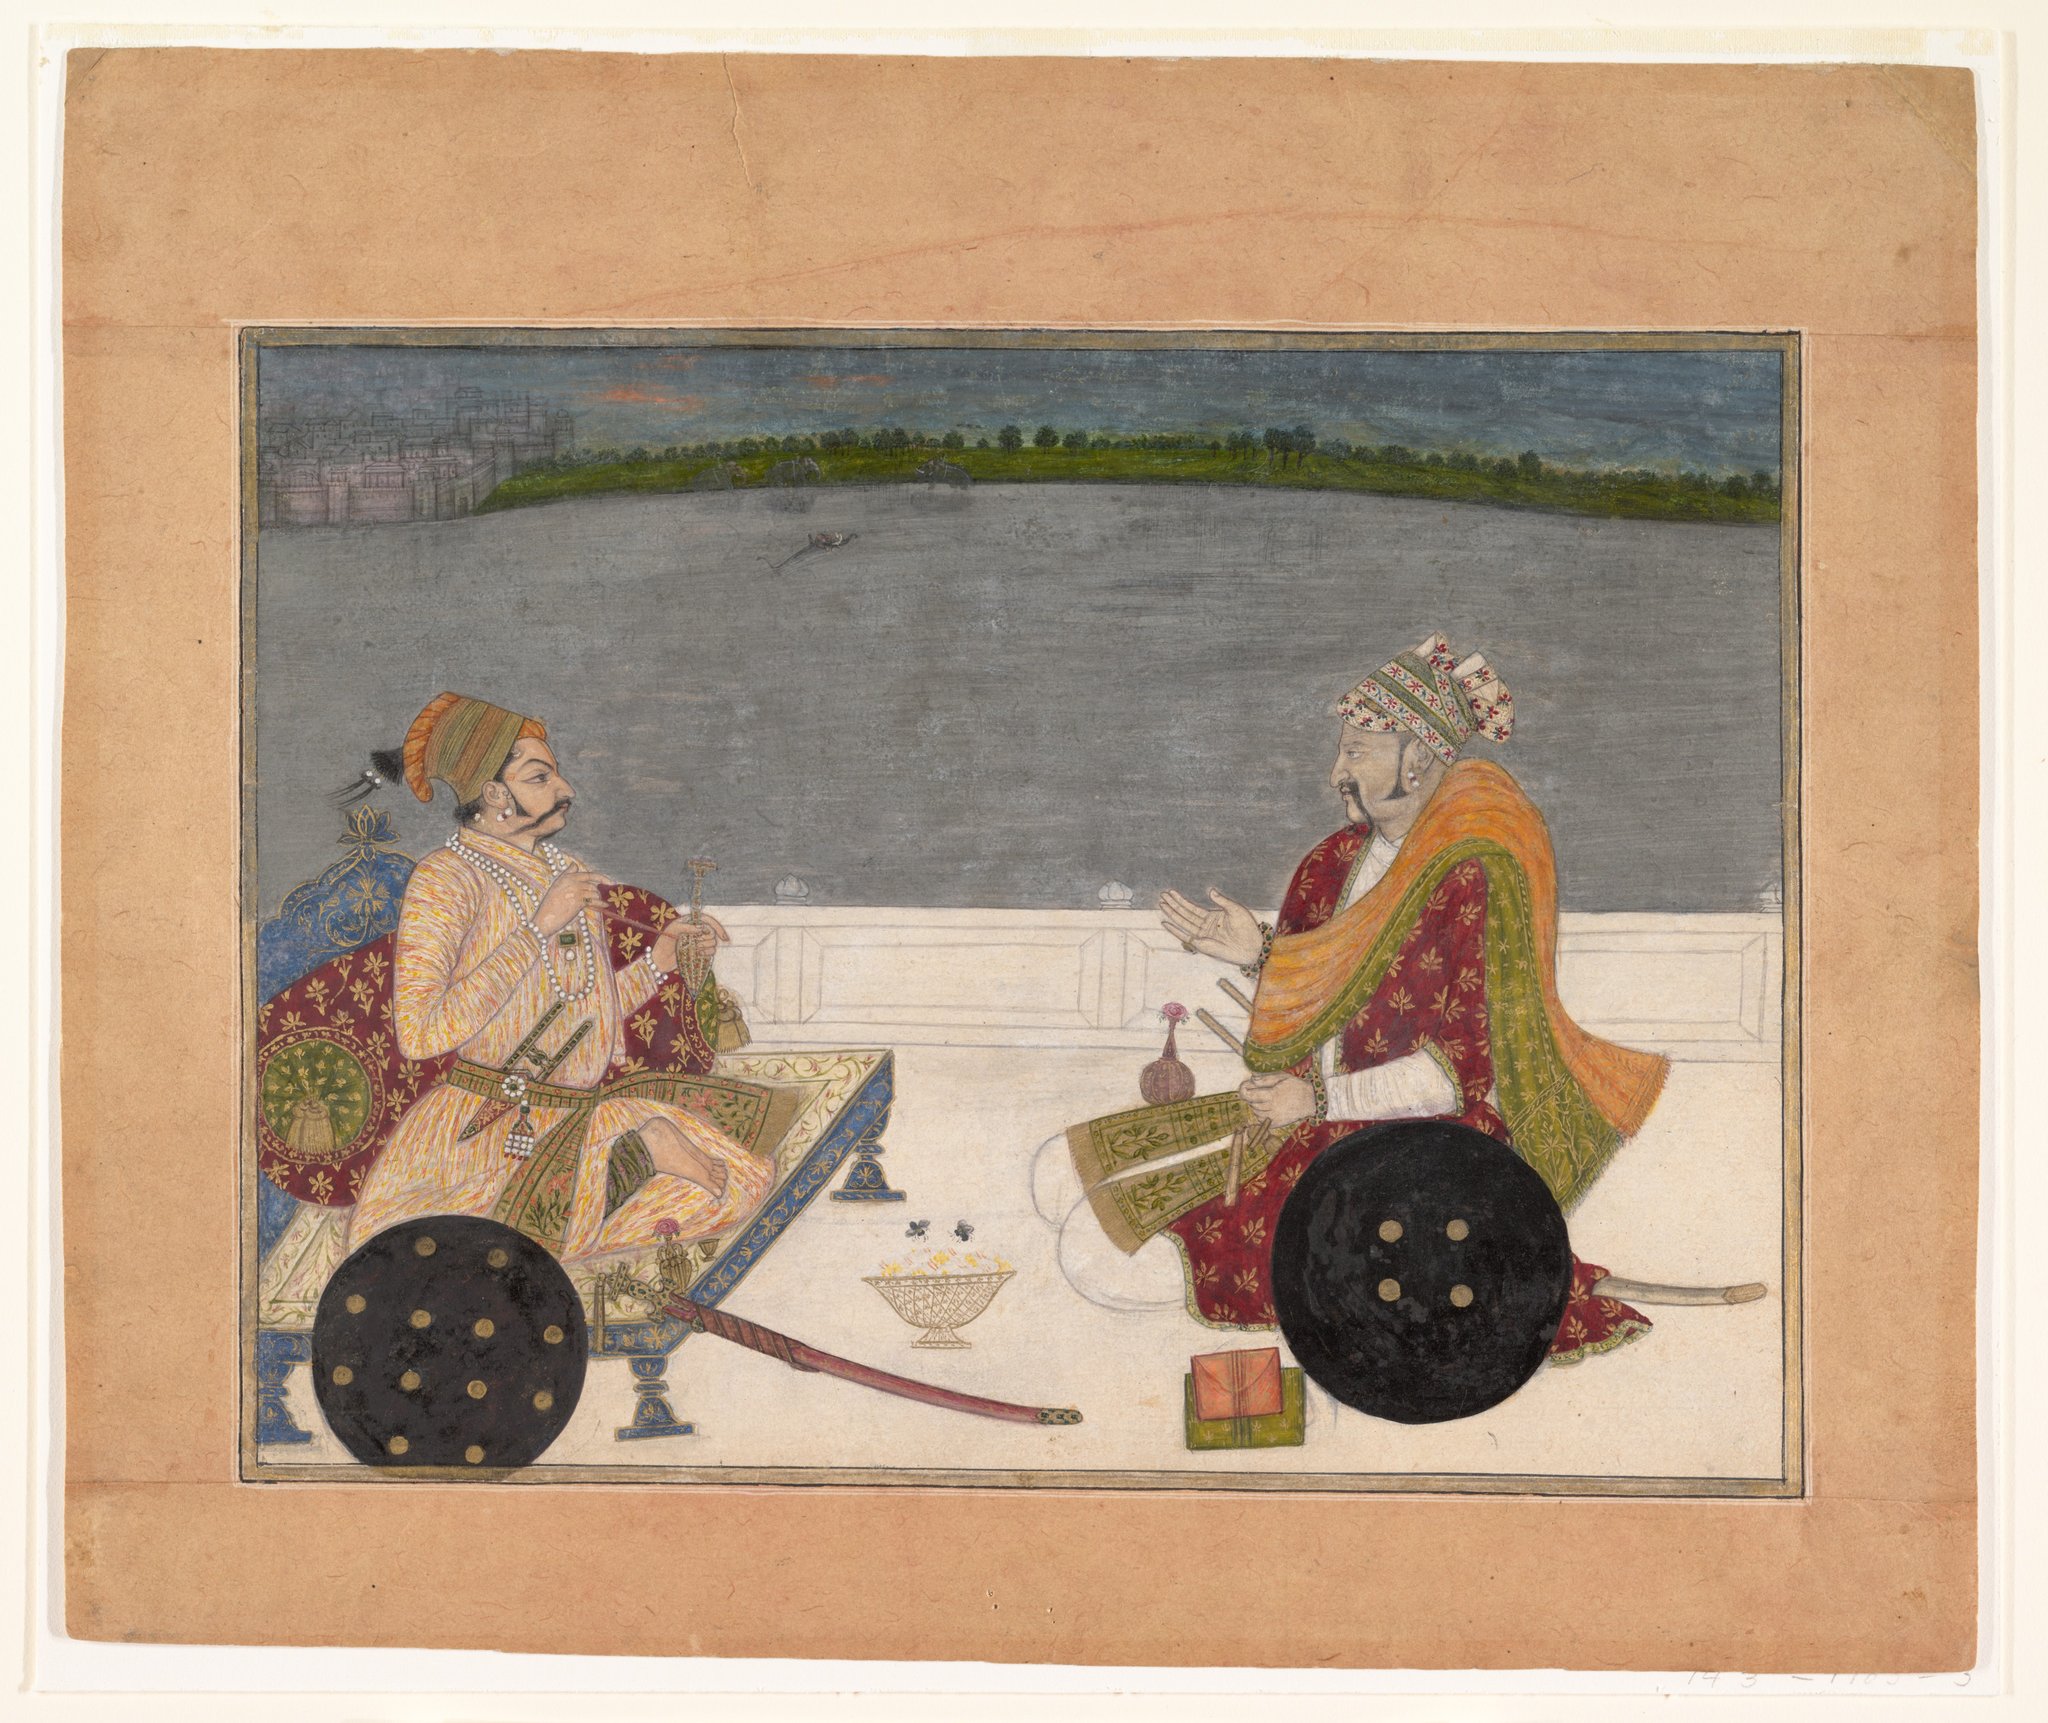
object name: painting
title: Prince Padam Singh of Bikaner with His Bard Gordhar on a Terrace at Night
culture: indian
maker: bhavani das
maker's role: artist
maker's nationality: indian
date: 1725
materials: gold, ink, paper, silver, watercolor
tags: swords,men,hookah